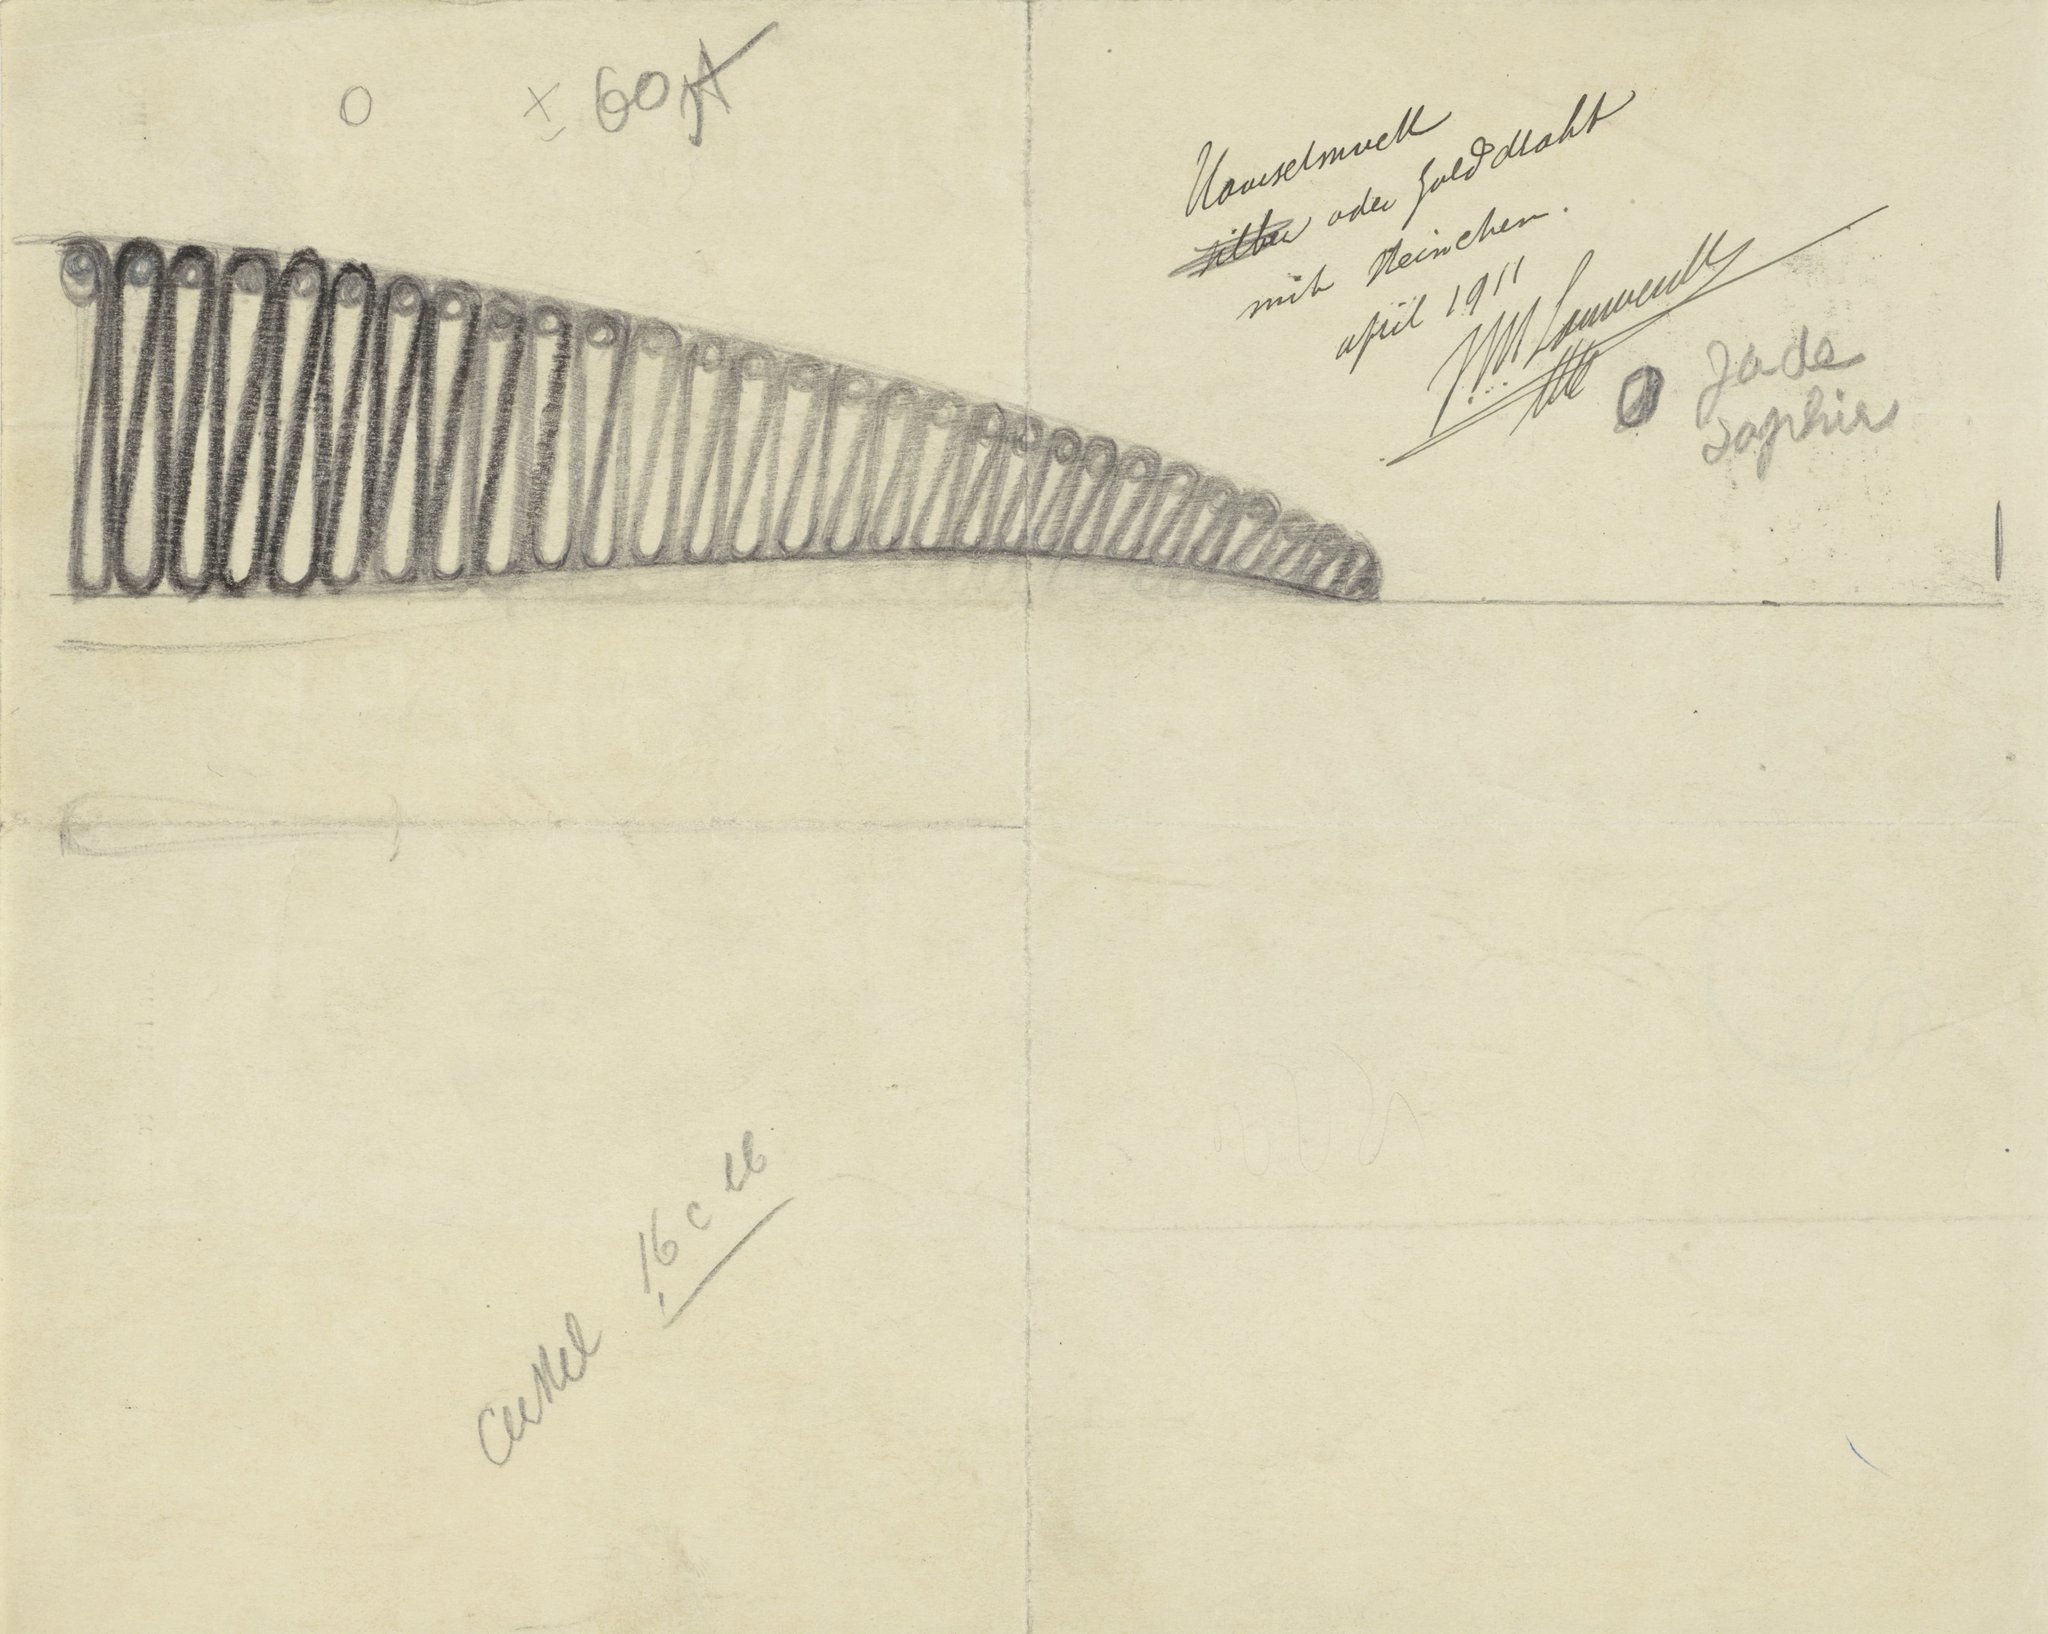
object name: design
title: Ontwerp voor een haarsieraad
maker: mathieu lauweriks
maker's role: designer, draughtsman, print maker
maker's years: 1864-1932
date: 1904-1911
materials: paper, pencil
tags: comb, brush and other tools (care of the hair), ornaments, jewels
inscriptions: date: ‘april 1911’